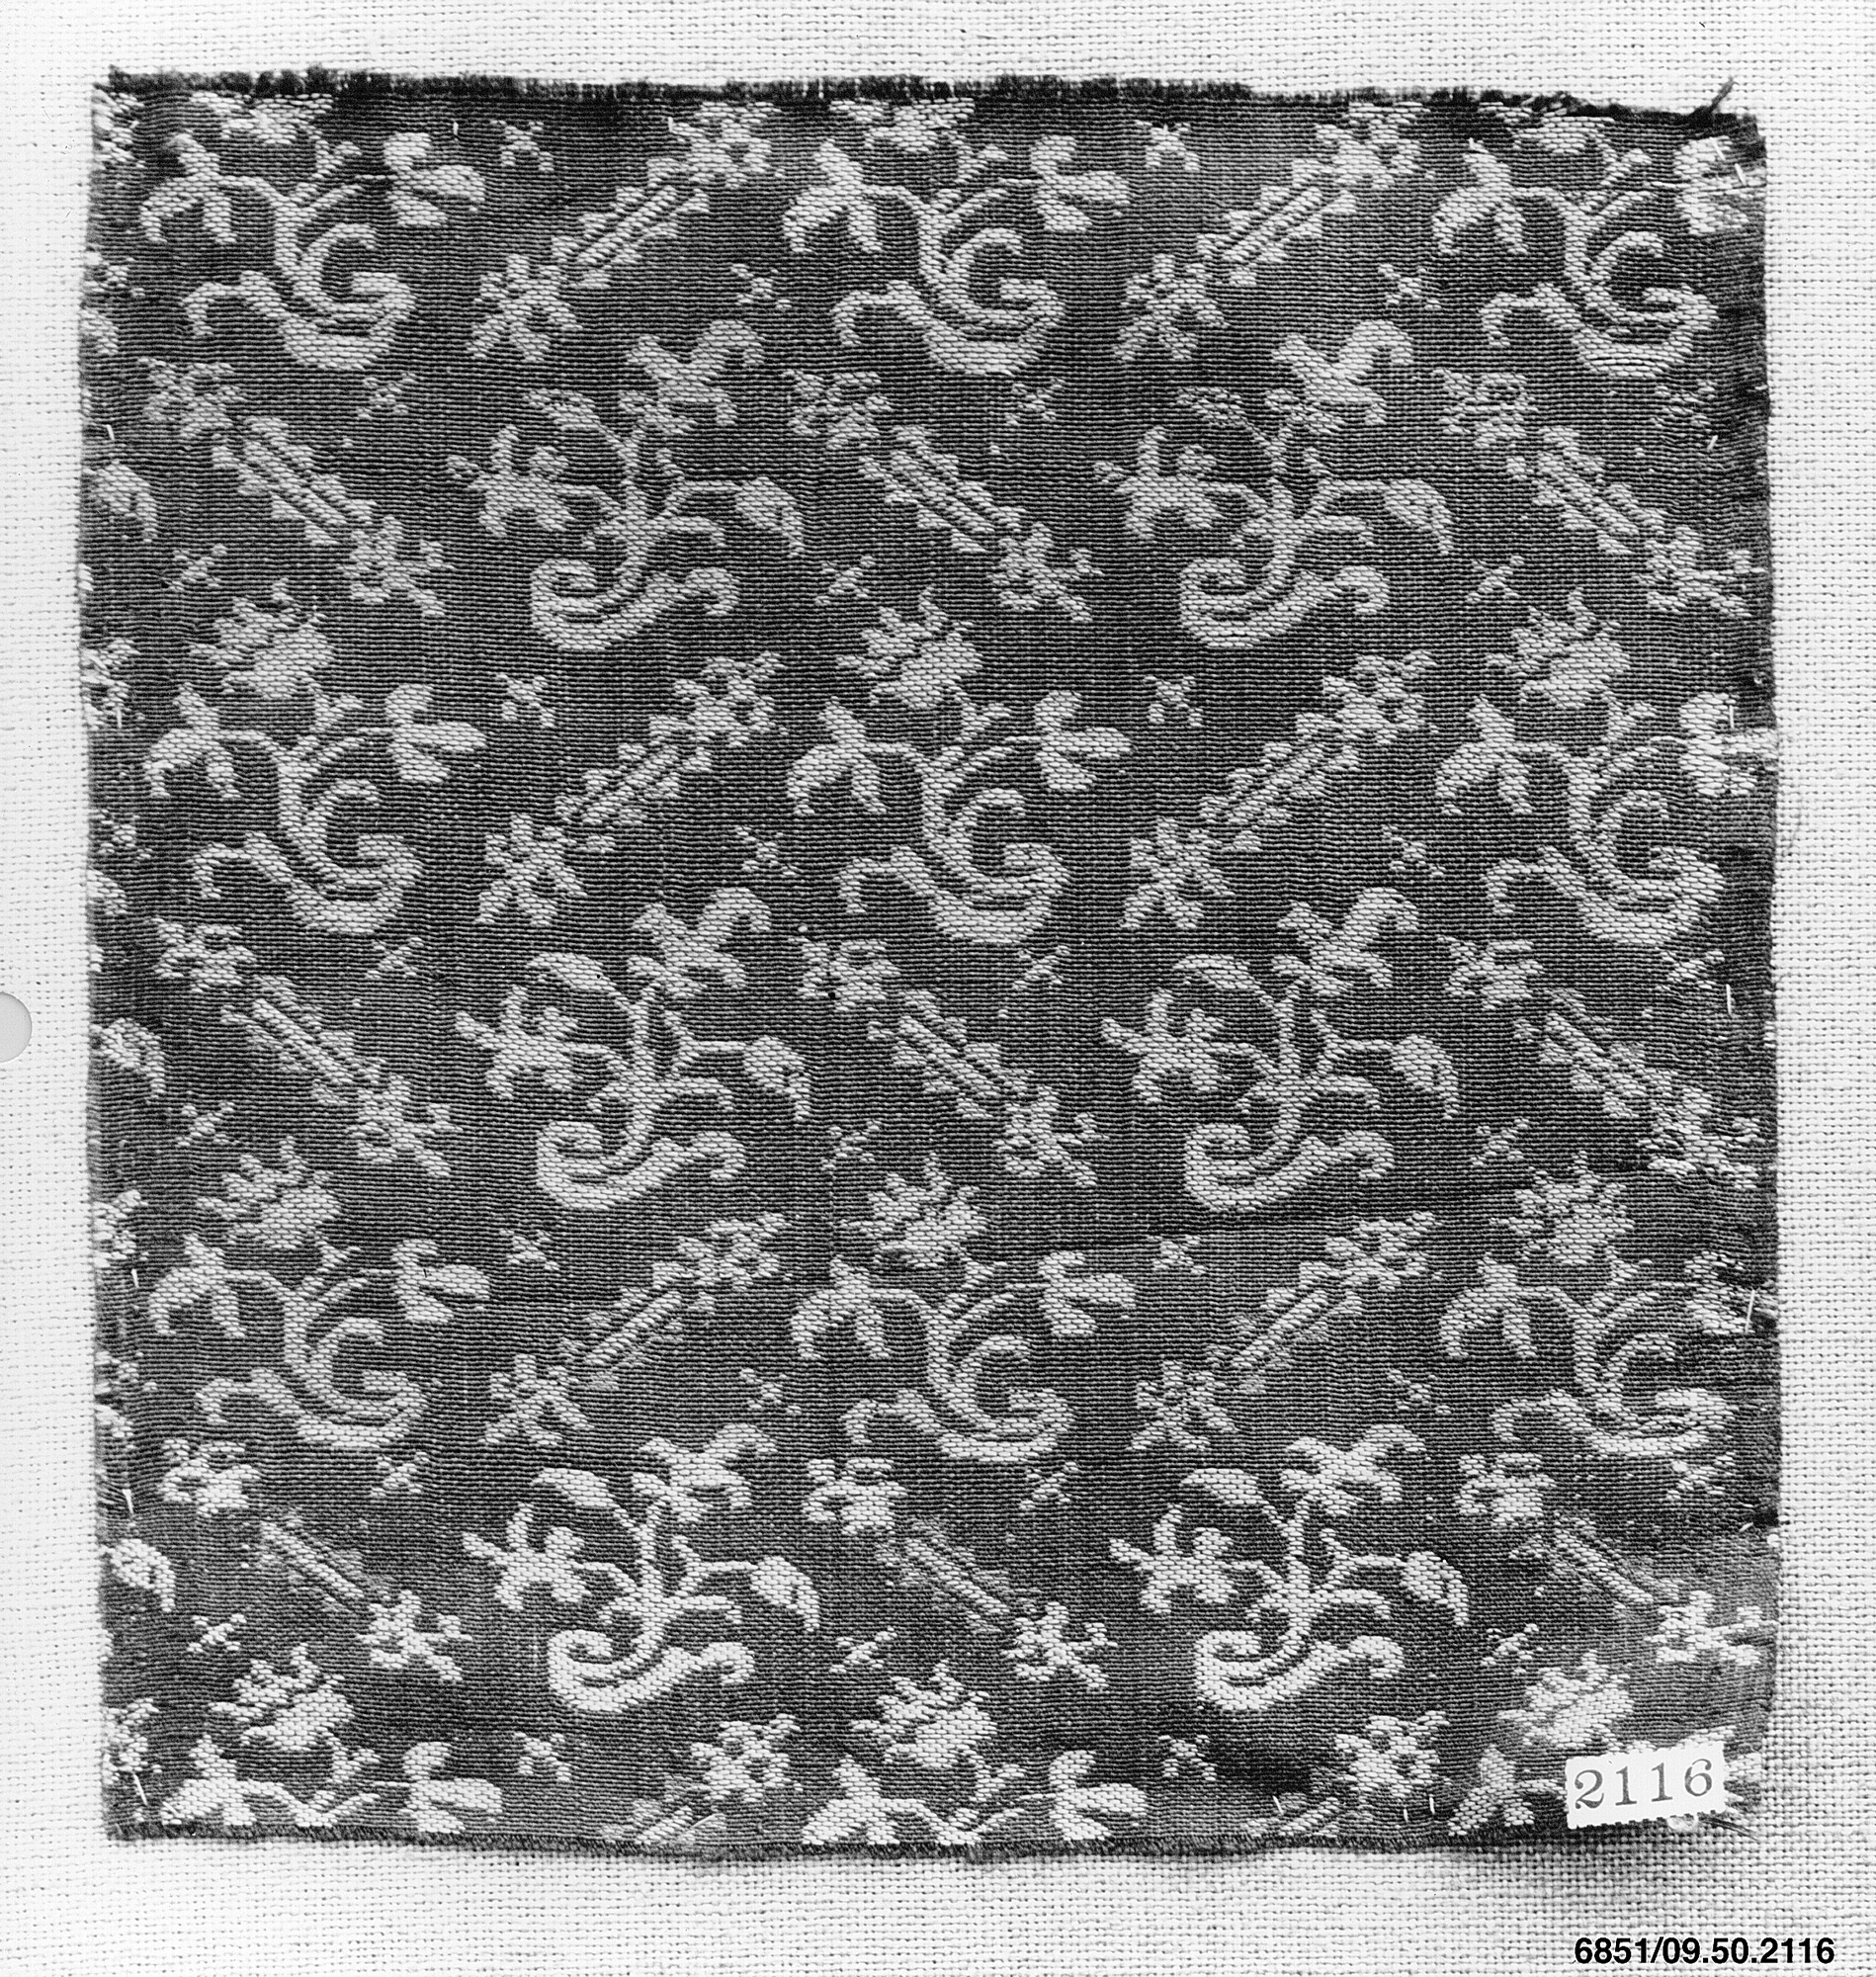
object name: piece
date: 1601-1700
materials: silk